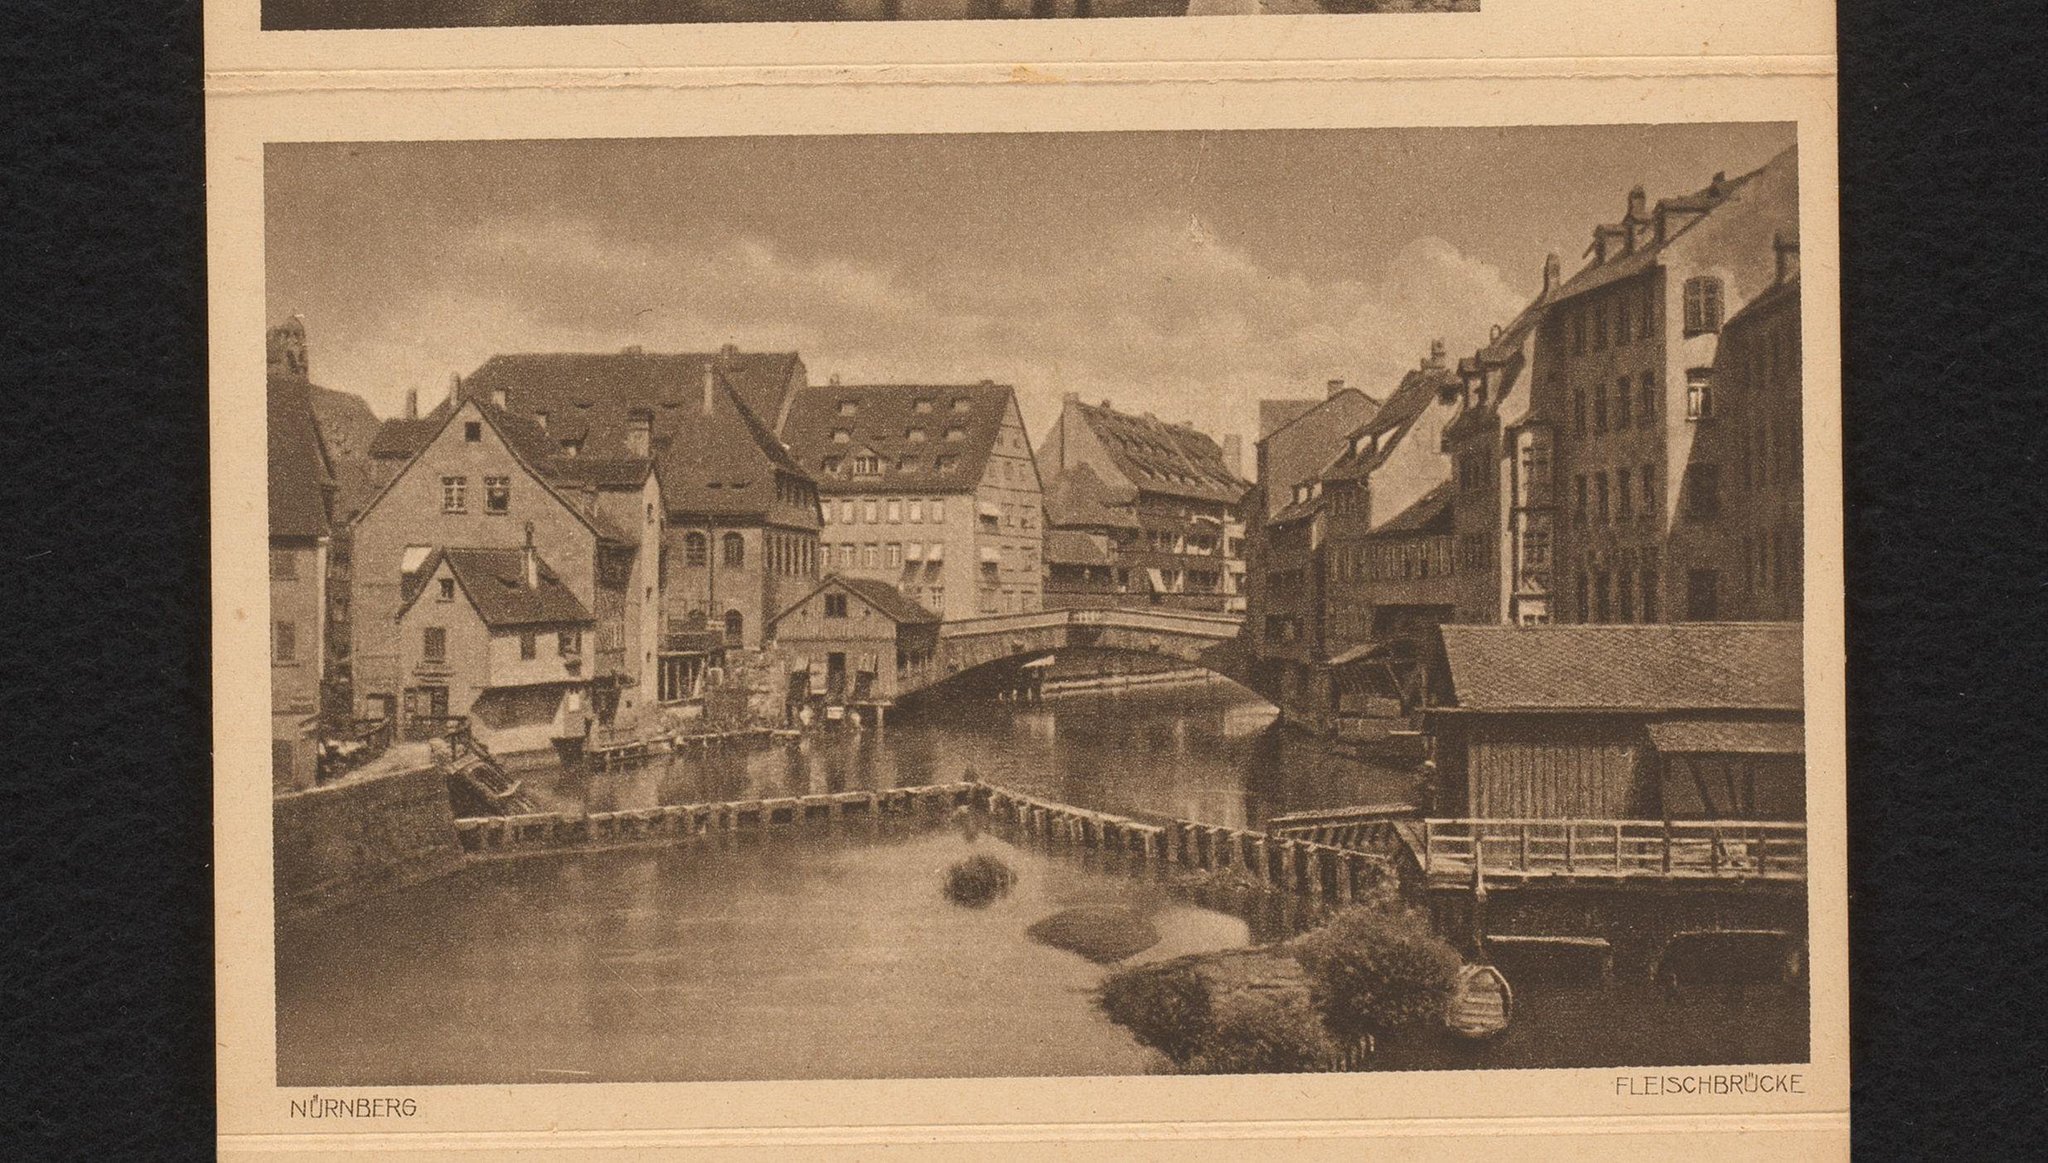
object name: photomechanical print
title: Nürnberg. Einfluss d. Pegnitz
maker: Anonymous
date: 1905-1930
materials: cardboard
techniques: rotogravure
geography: nuremberg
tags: canals, waters (in city), bridge in city across river, canal, etc.